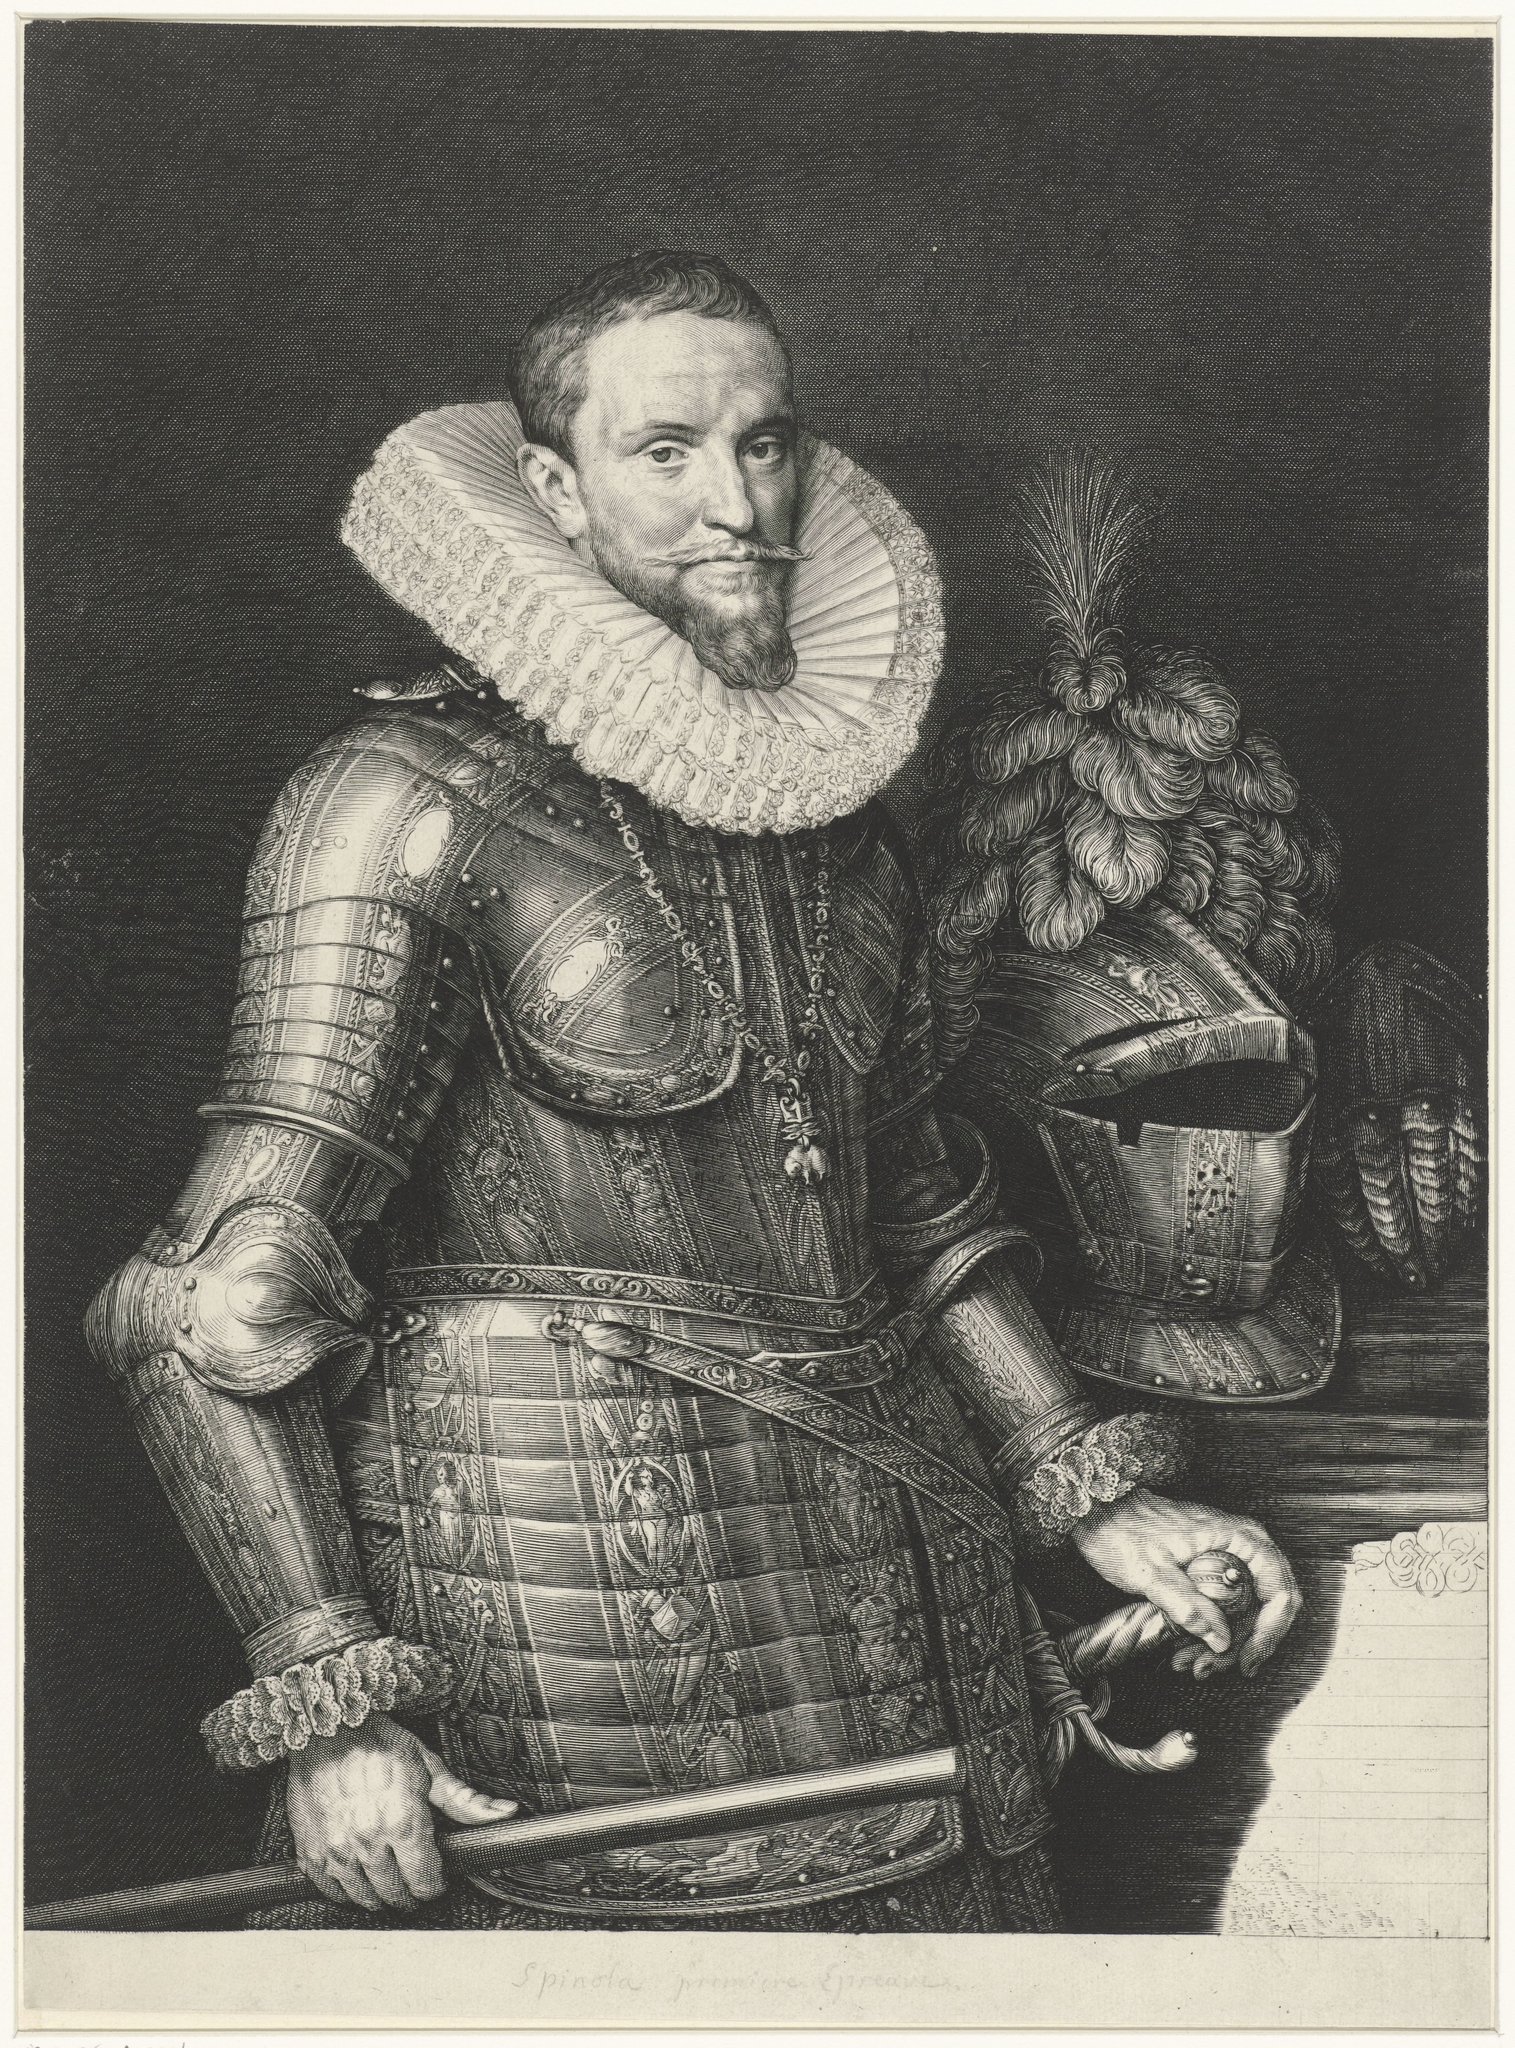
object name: print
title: Portret van Ambrogio Spinola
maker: jan harmensz. muller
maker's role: draughtsman, print maker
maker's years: 1571-1628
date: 1615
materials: paper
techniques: engraving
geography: amsterdam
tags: helmet, historical persons, knighthood order of the golden fleece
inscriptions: collector's mark: Lugt 2228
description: Portret van Ambrogio Spinola, markies de los Balbases, gekleed in harnas met een bevelhebbersstaf in zijn hand. Rechts op tafel zijn helm.